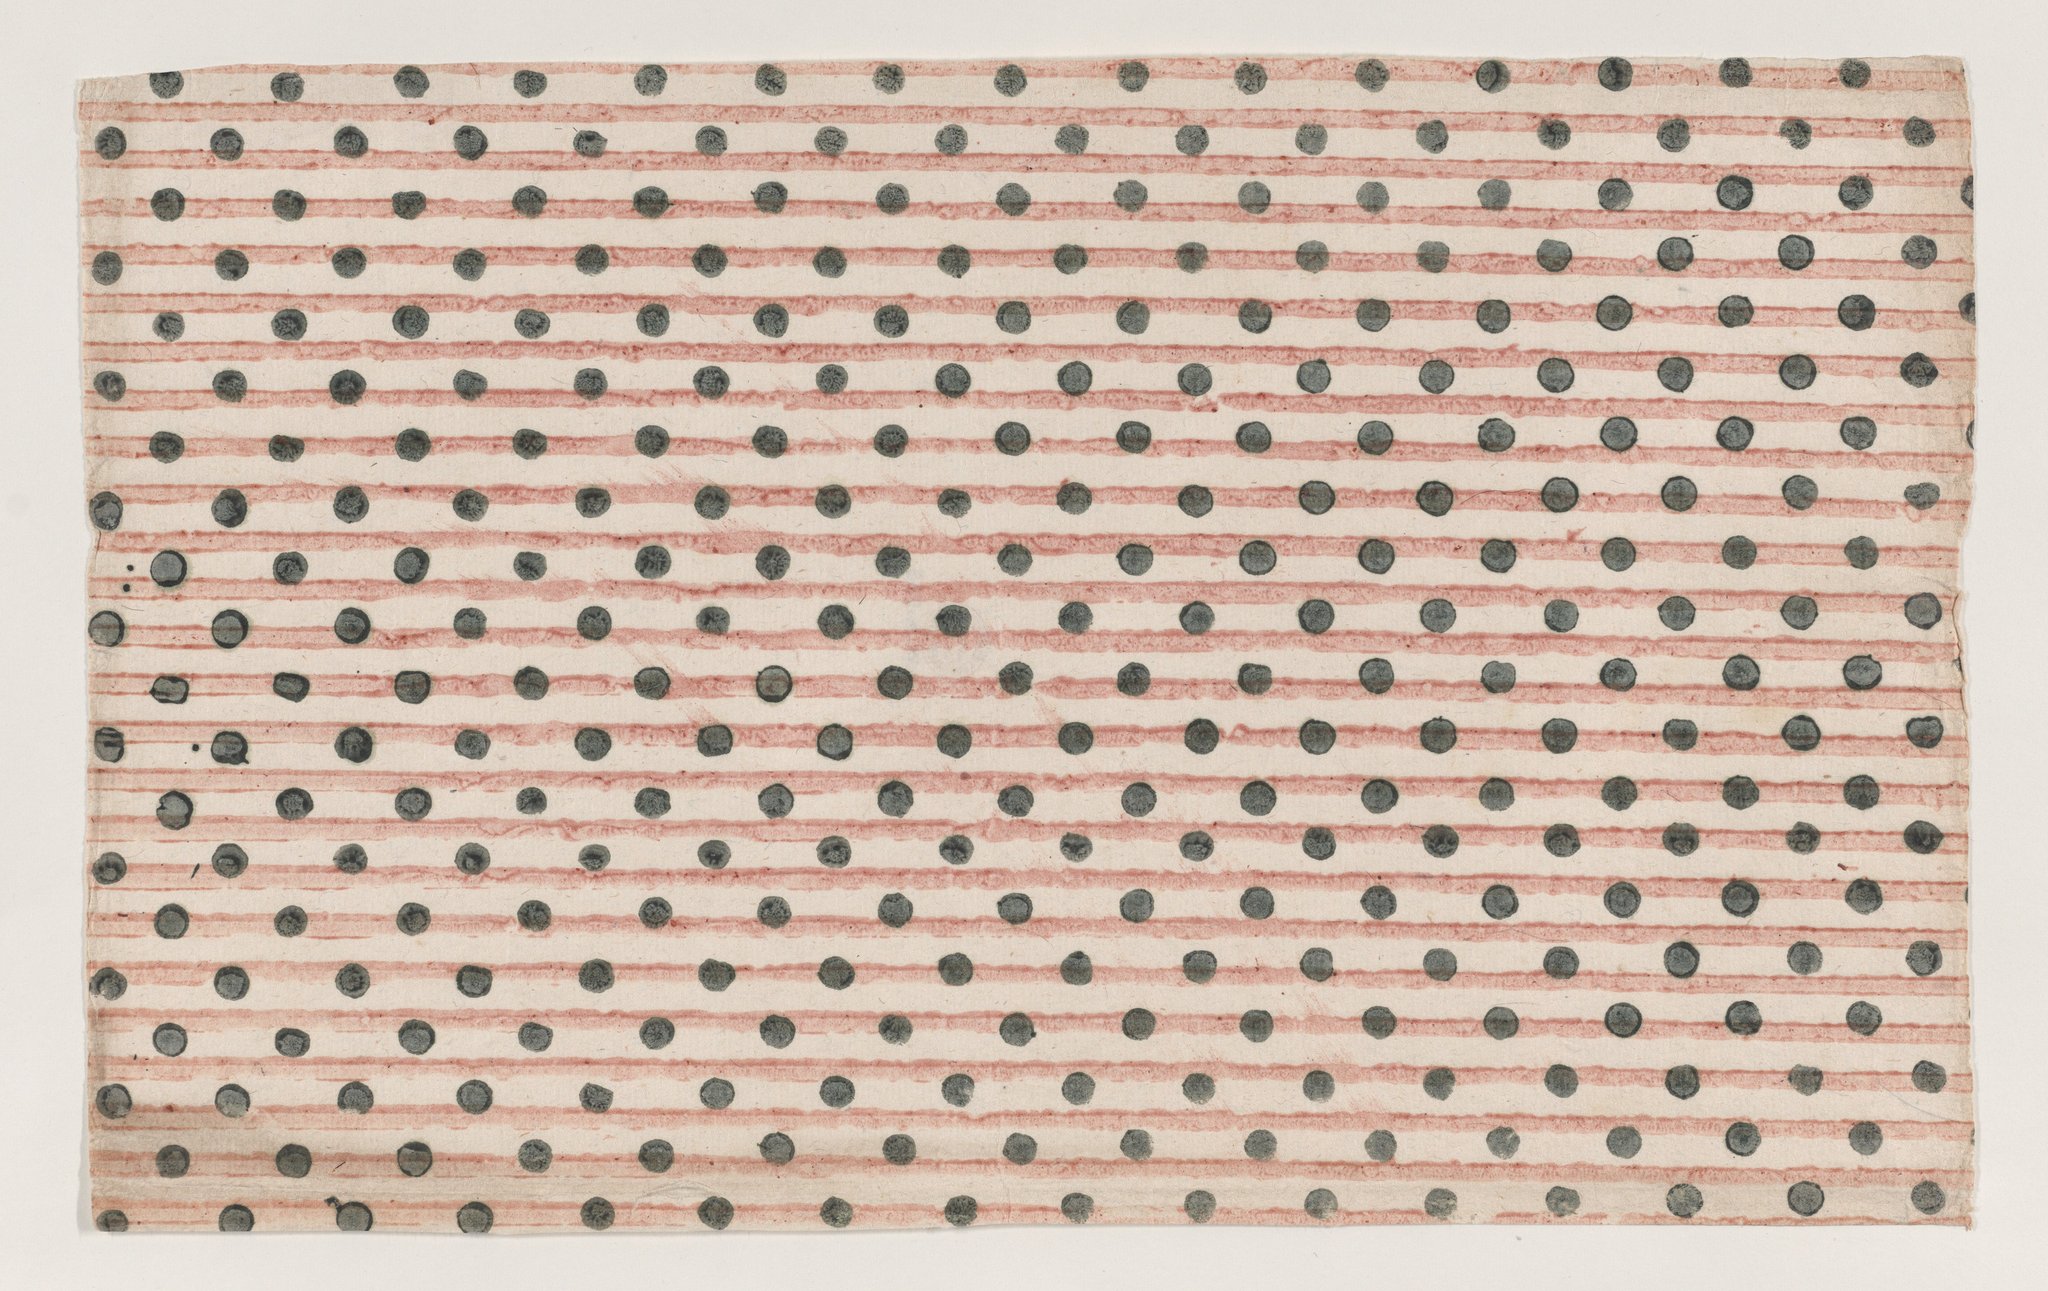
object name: print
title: Sheet with overall stripe and dot design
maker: Anonymous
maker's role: artist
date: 1801-1900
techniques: relief print